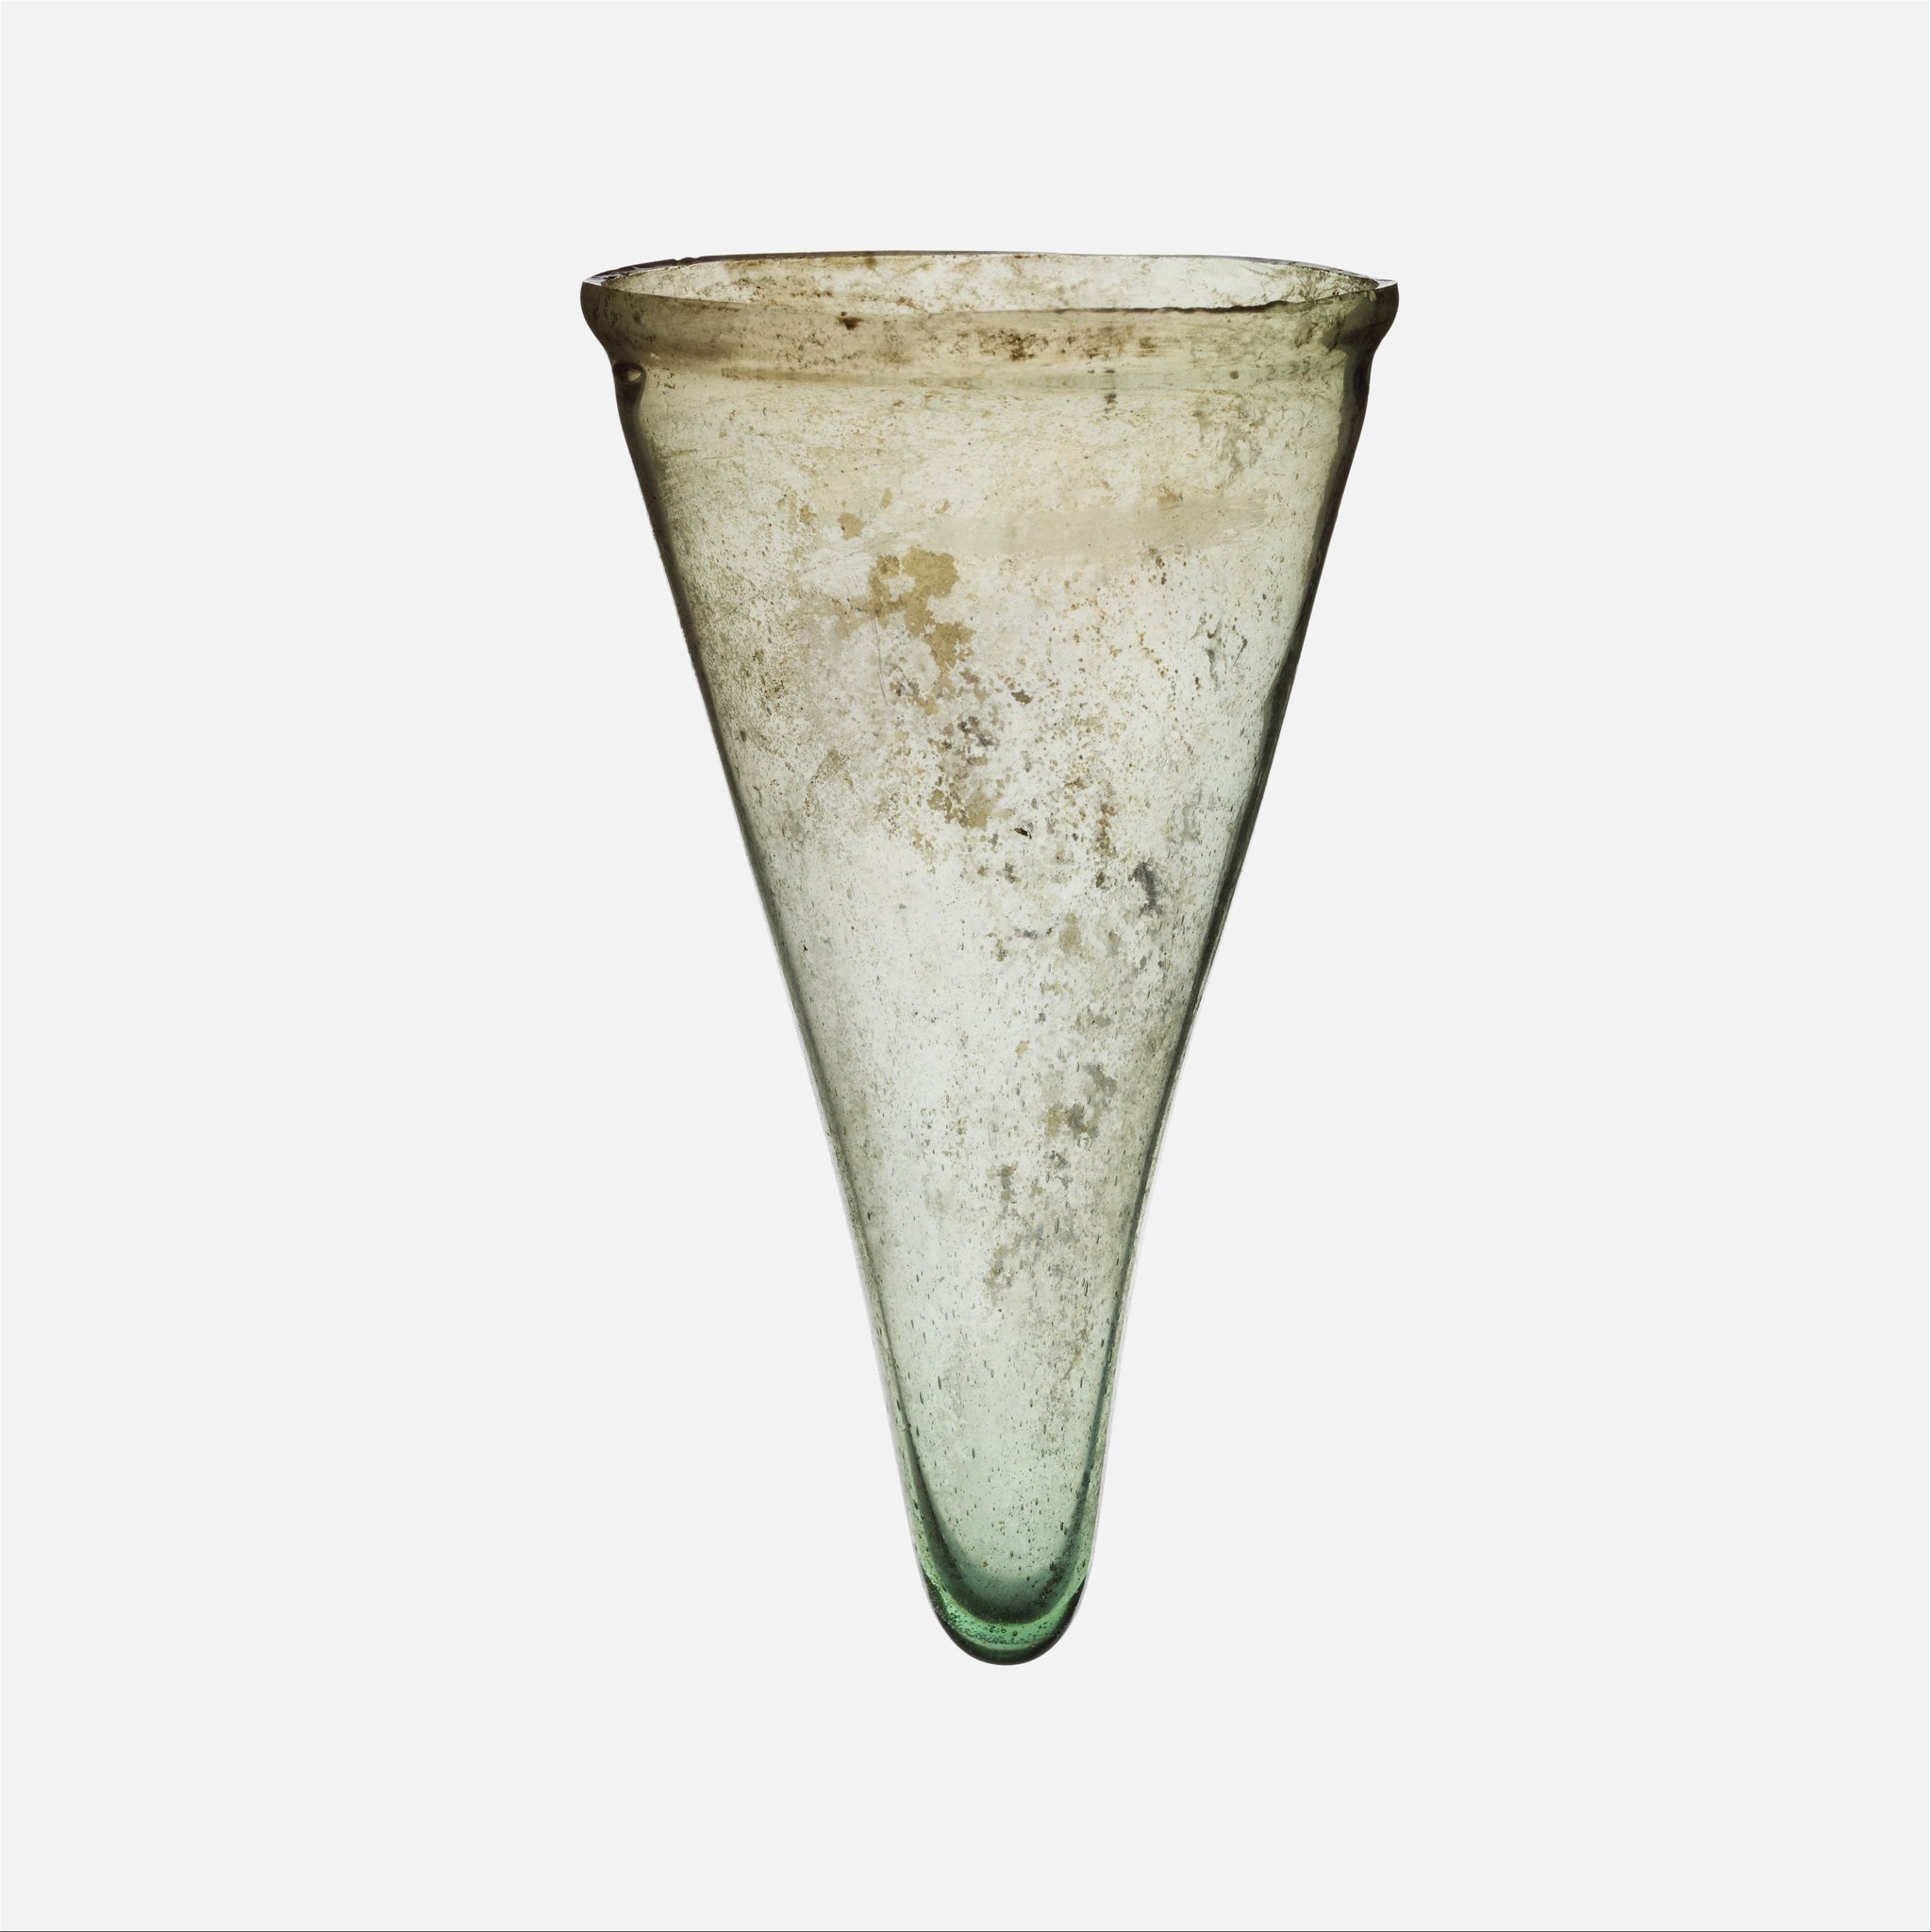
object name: beaker or lamp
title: Glass lamp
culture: roman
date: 301-400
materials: glass